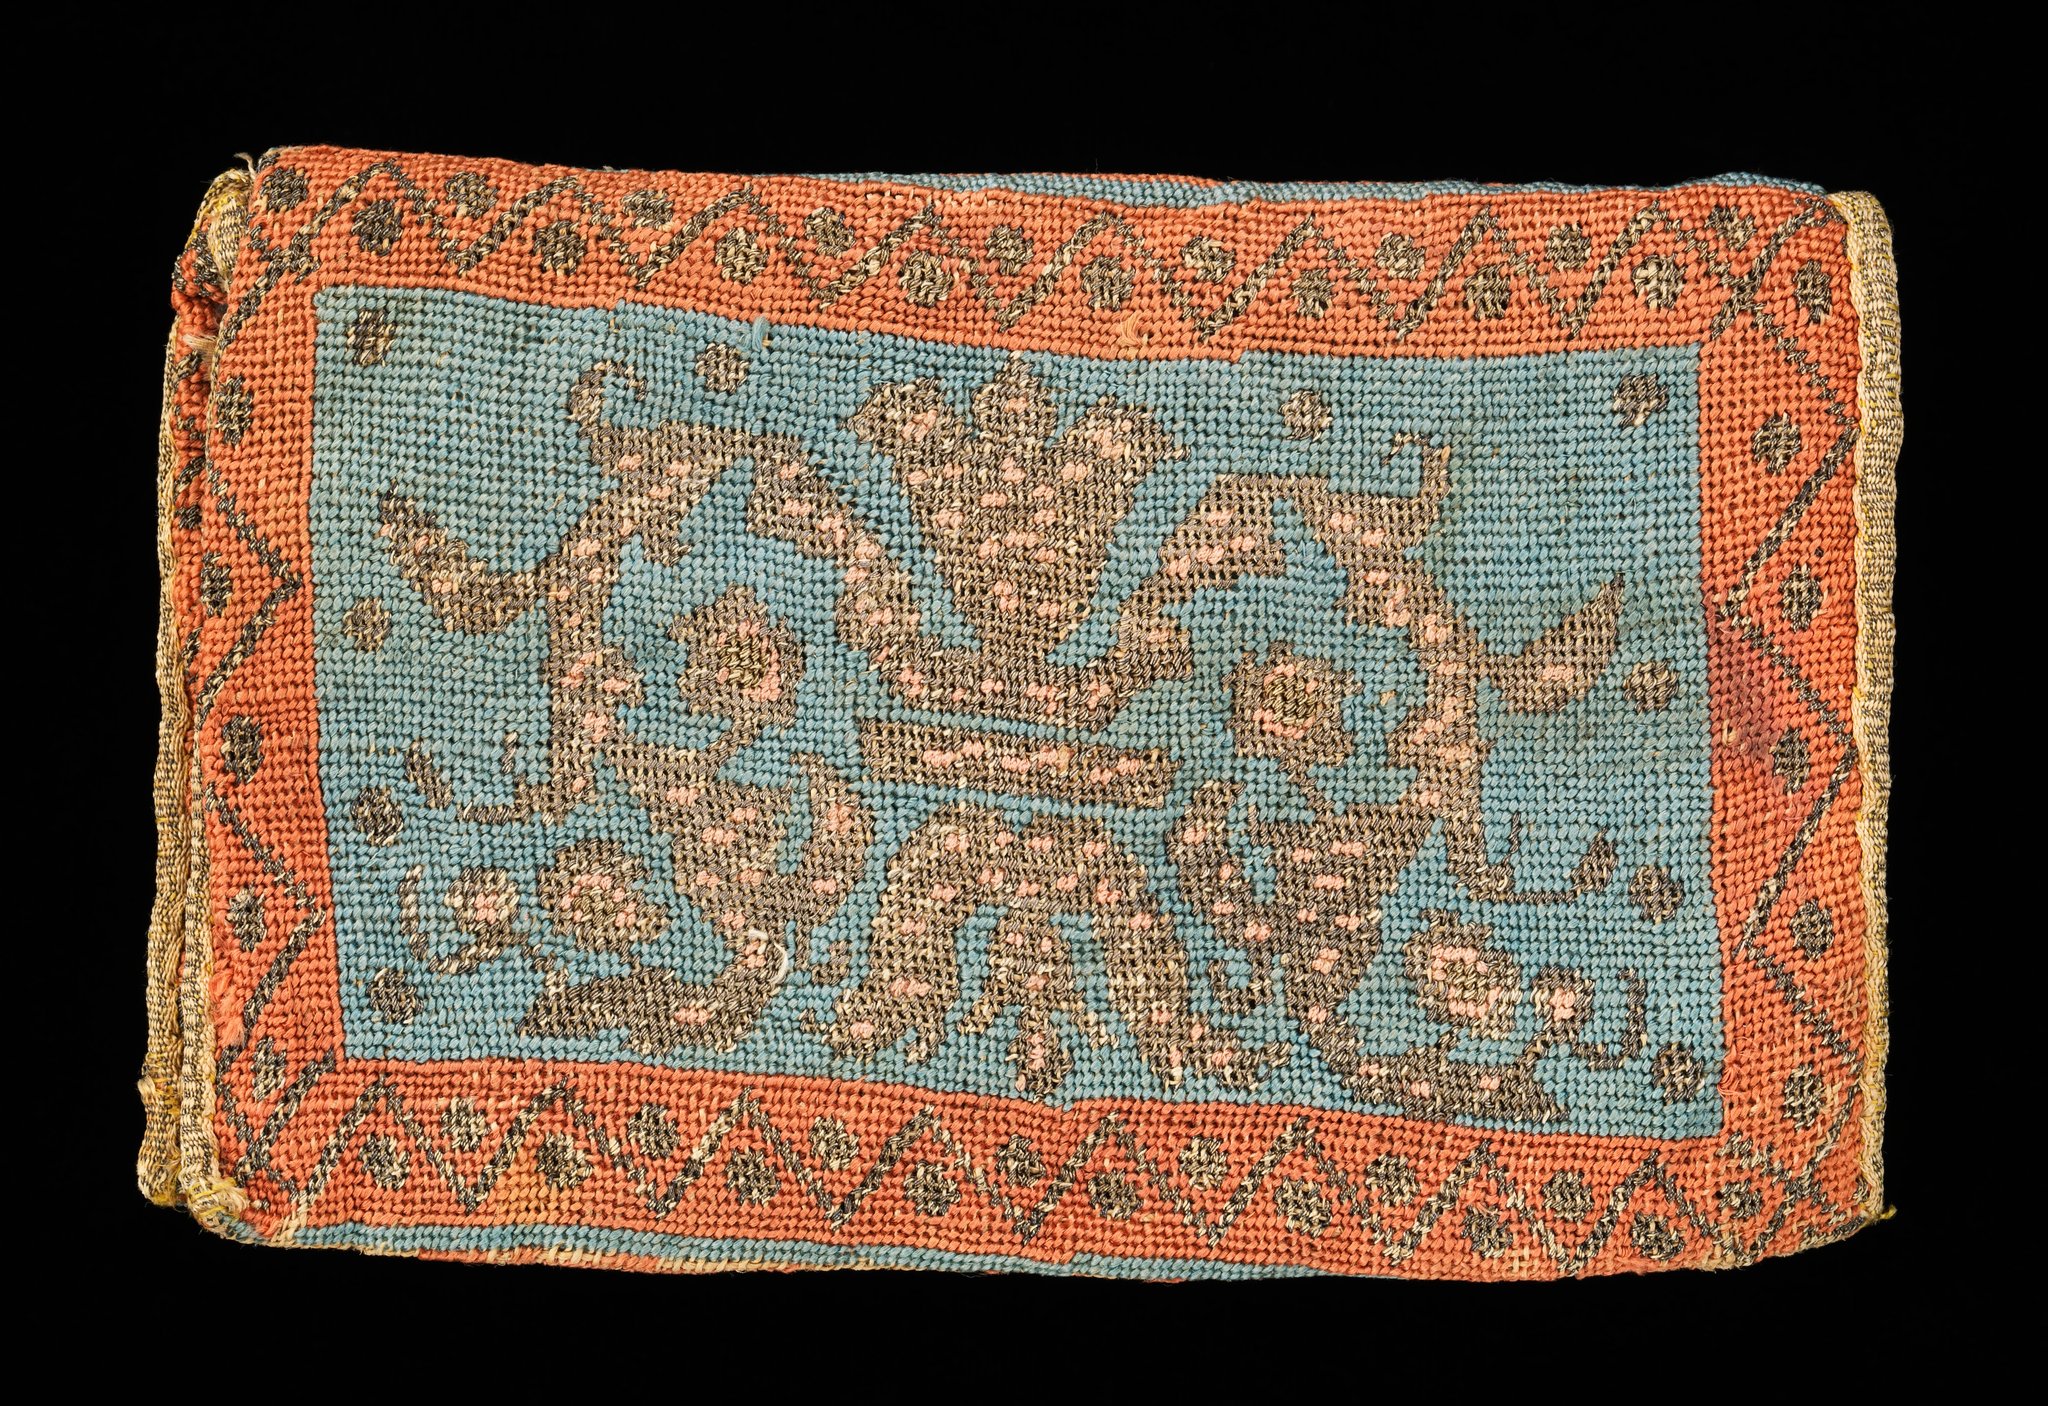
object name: purse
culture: european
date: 1767-1800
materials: linen, metal, silk